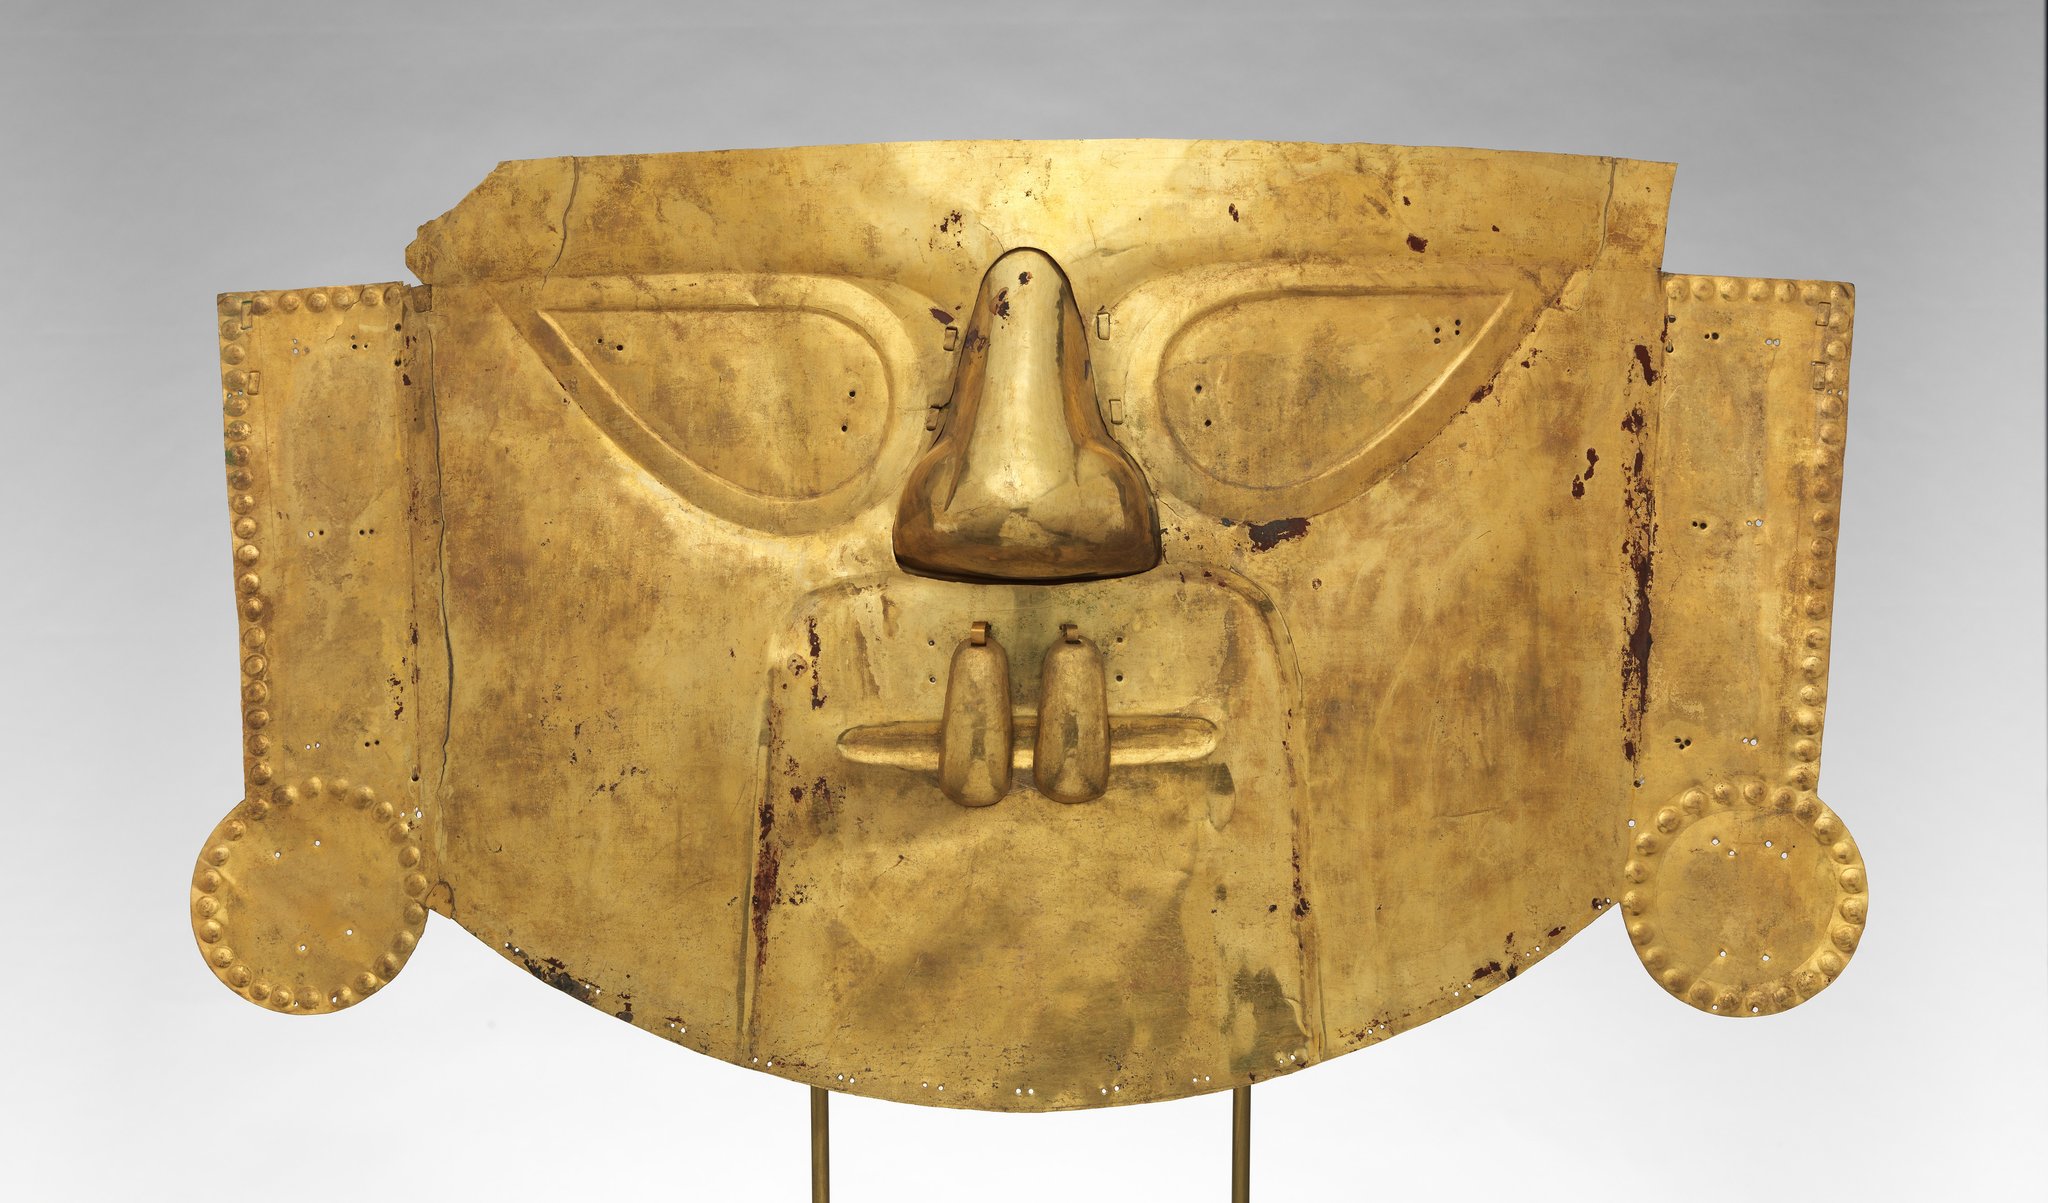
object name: mask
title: Funerary mask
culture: lambayeque, sicán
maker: lambayeque (sicán) artist(s)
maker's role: artist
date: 900-1100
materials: gold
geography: peru